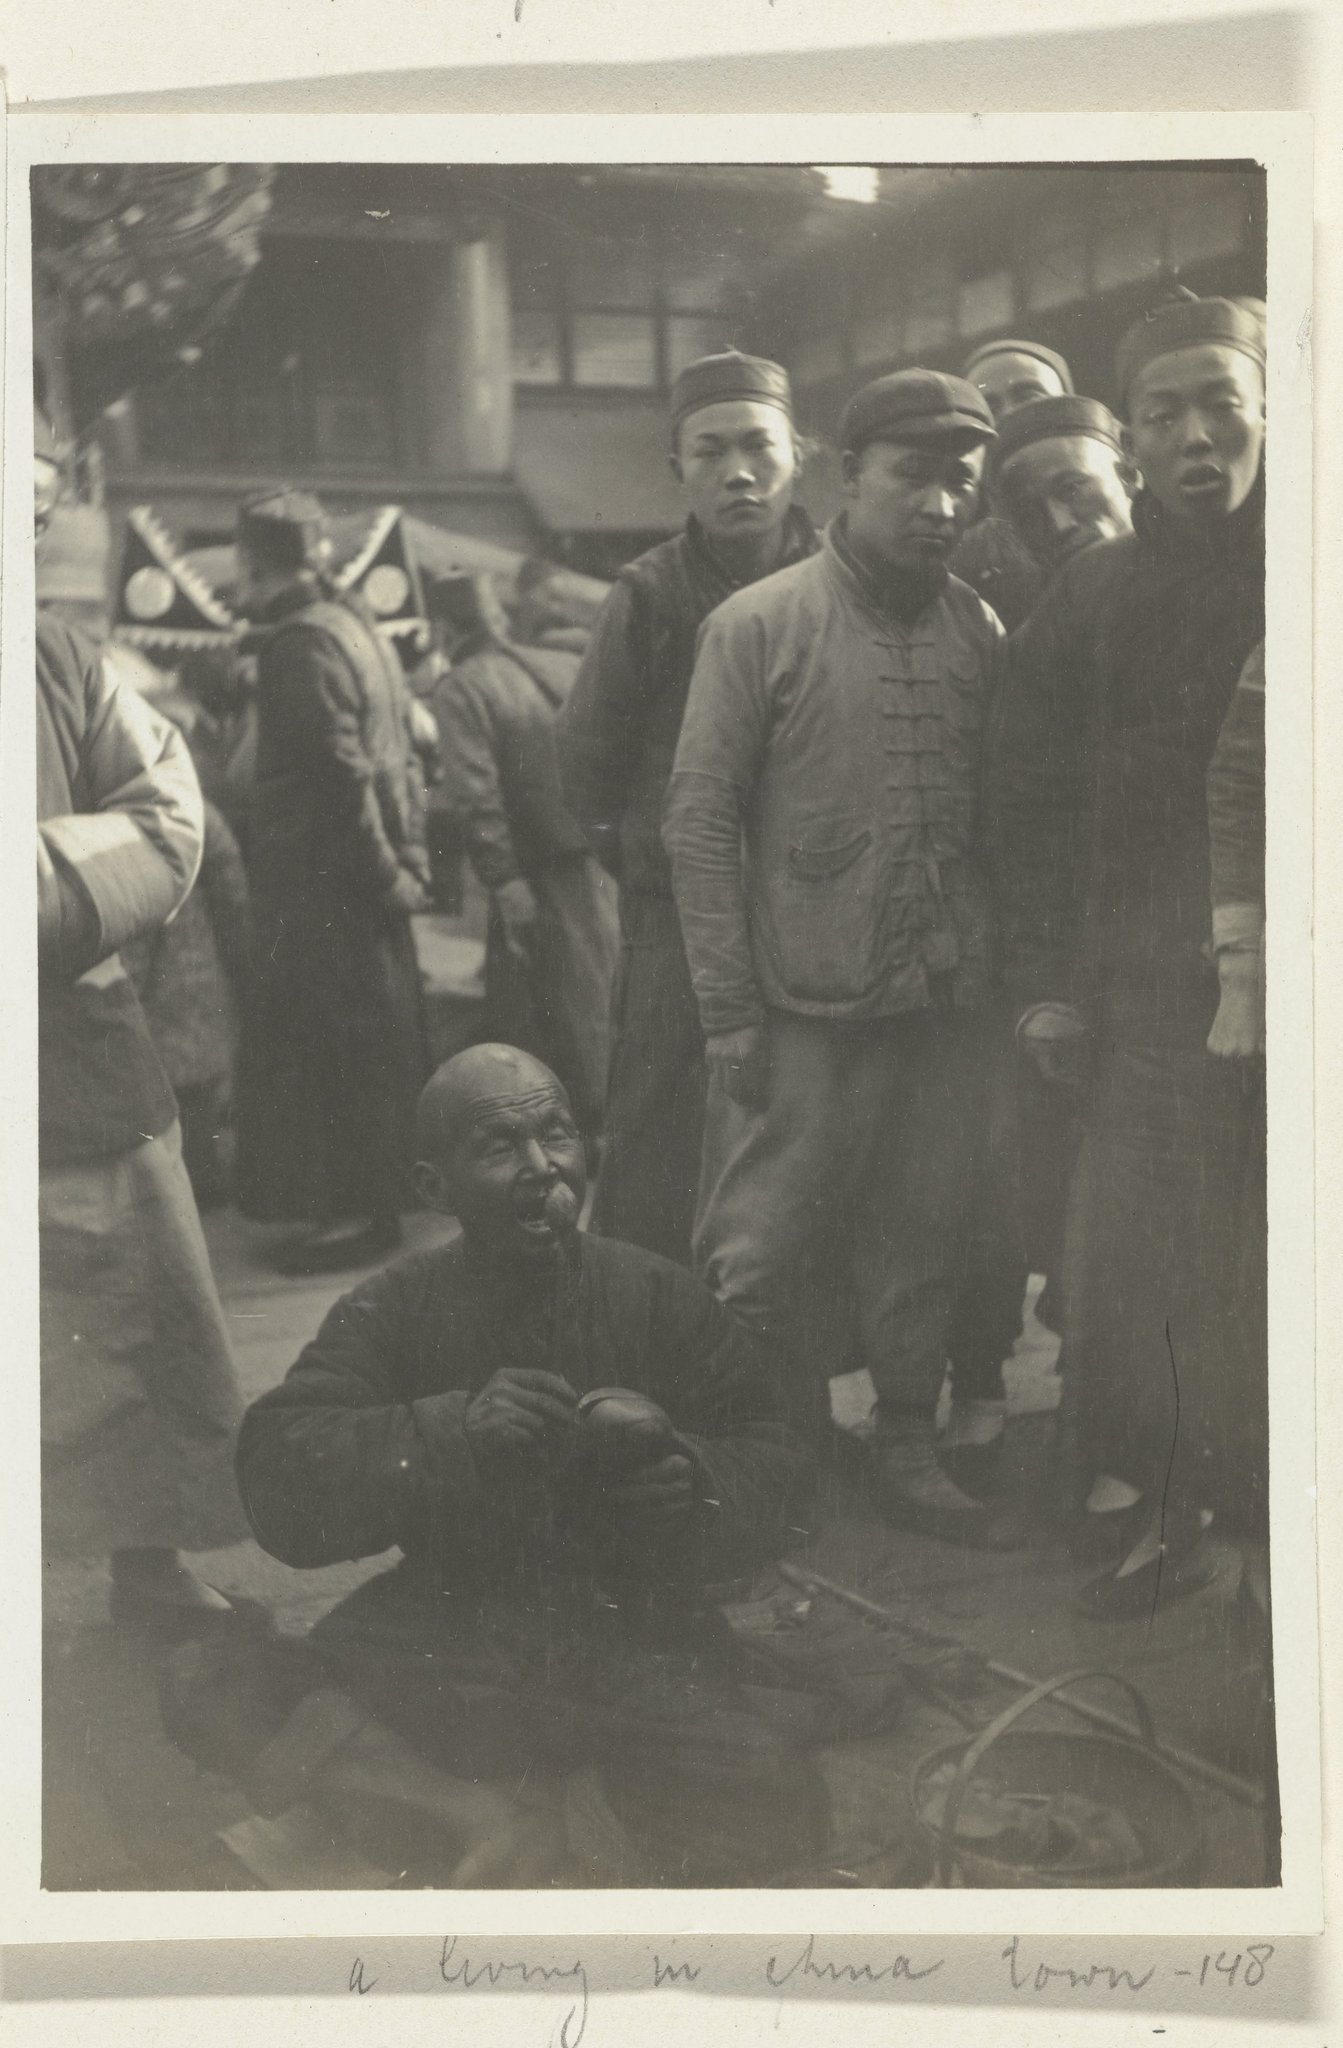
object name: photograph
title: A living in China town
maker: geldolph adriaan kessler (dolph)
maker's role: fotograaf, industrieel, voetballer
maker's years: 1884-1945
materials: cardboard, photographic support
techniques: gelatin silver print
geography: shanghai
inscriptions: title: ‘A living in china town’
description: Verkoper op de markt in Shanghai. Onderdeel van het fotoalbum van Dolph Kessler met opnamen die hij maakte tijdens zijn verblijf in Engeland en op een wereldreis die hij als secretaris van Henri Deterding (directeur Koninklijke Olie) ondernam naar Nederlands-Indië, Japan, China en de Verenigde Staten, tussen 1906 en 1908.